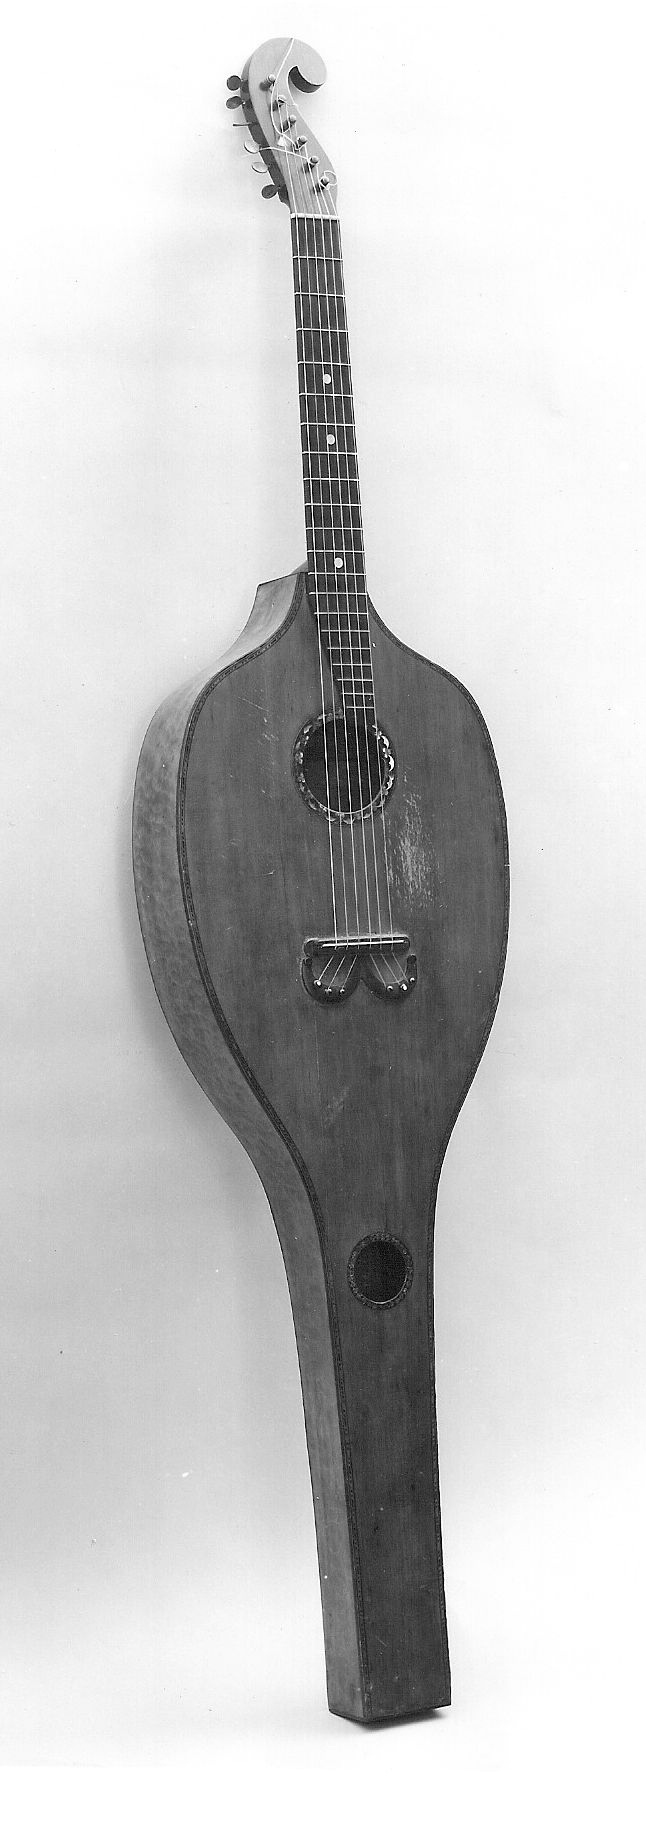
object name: harp guitar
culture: american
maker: emilius n. scherr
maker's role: maker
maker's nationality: american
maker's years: 1794-1874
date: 1831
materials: metal, wood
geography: united states